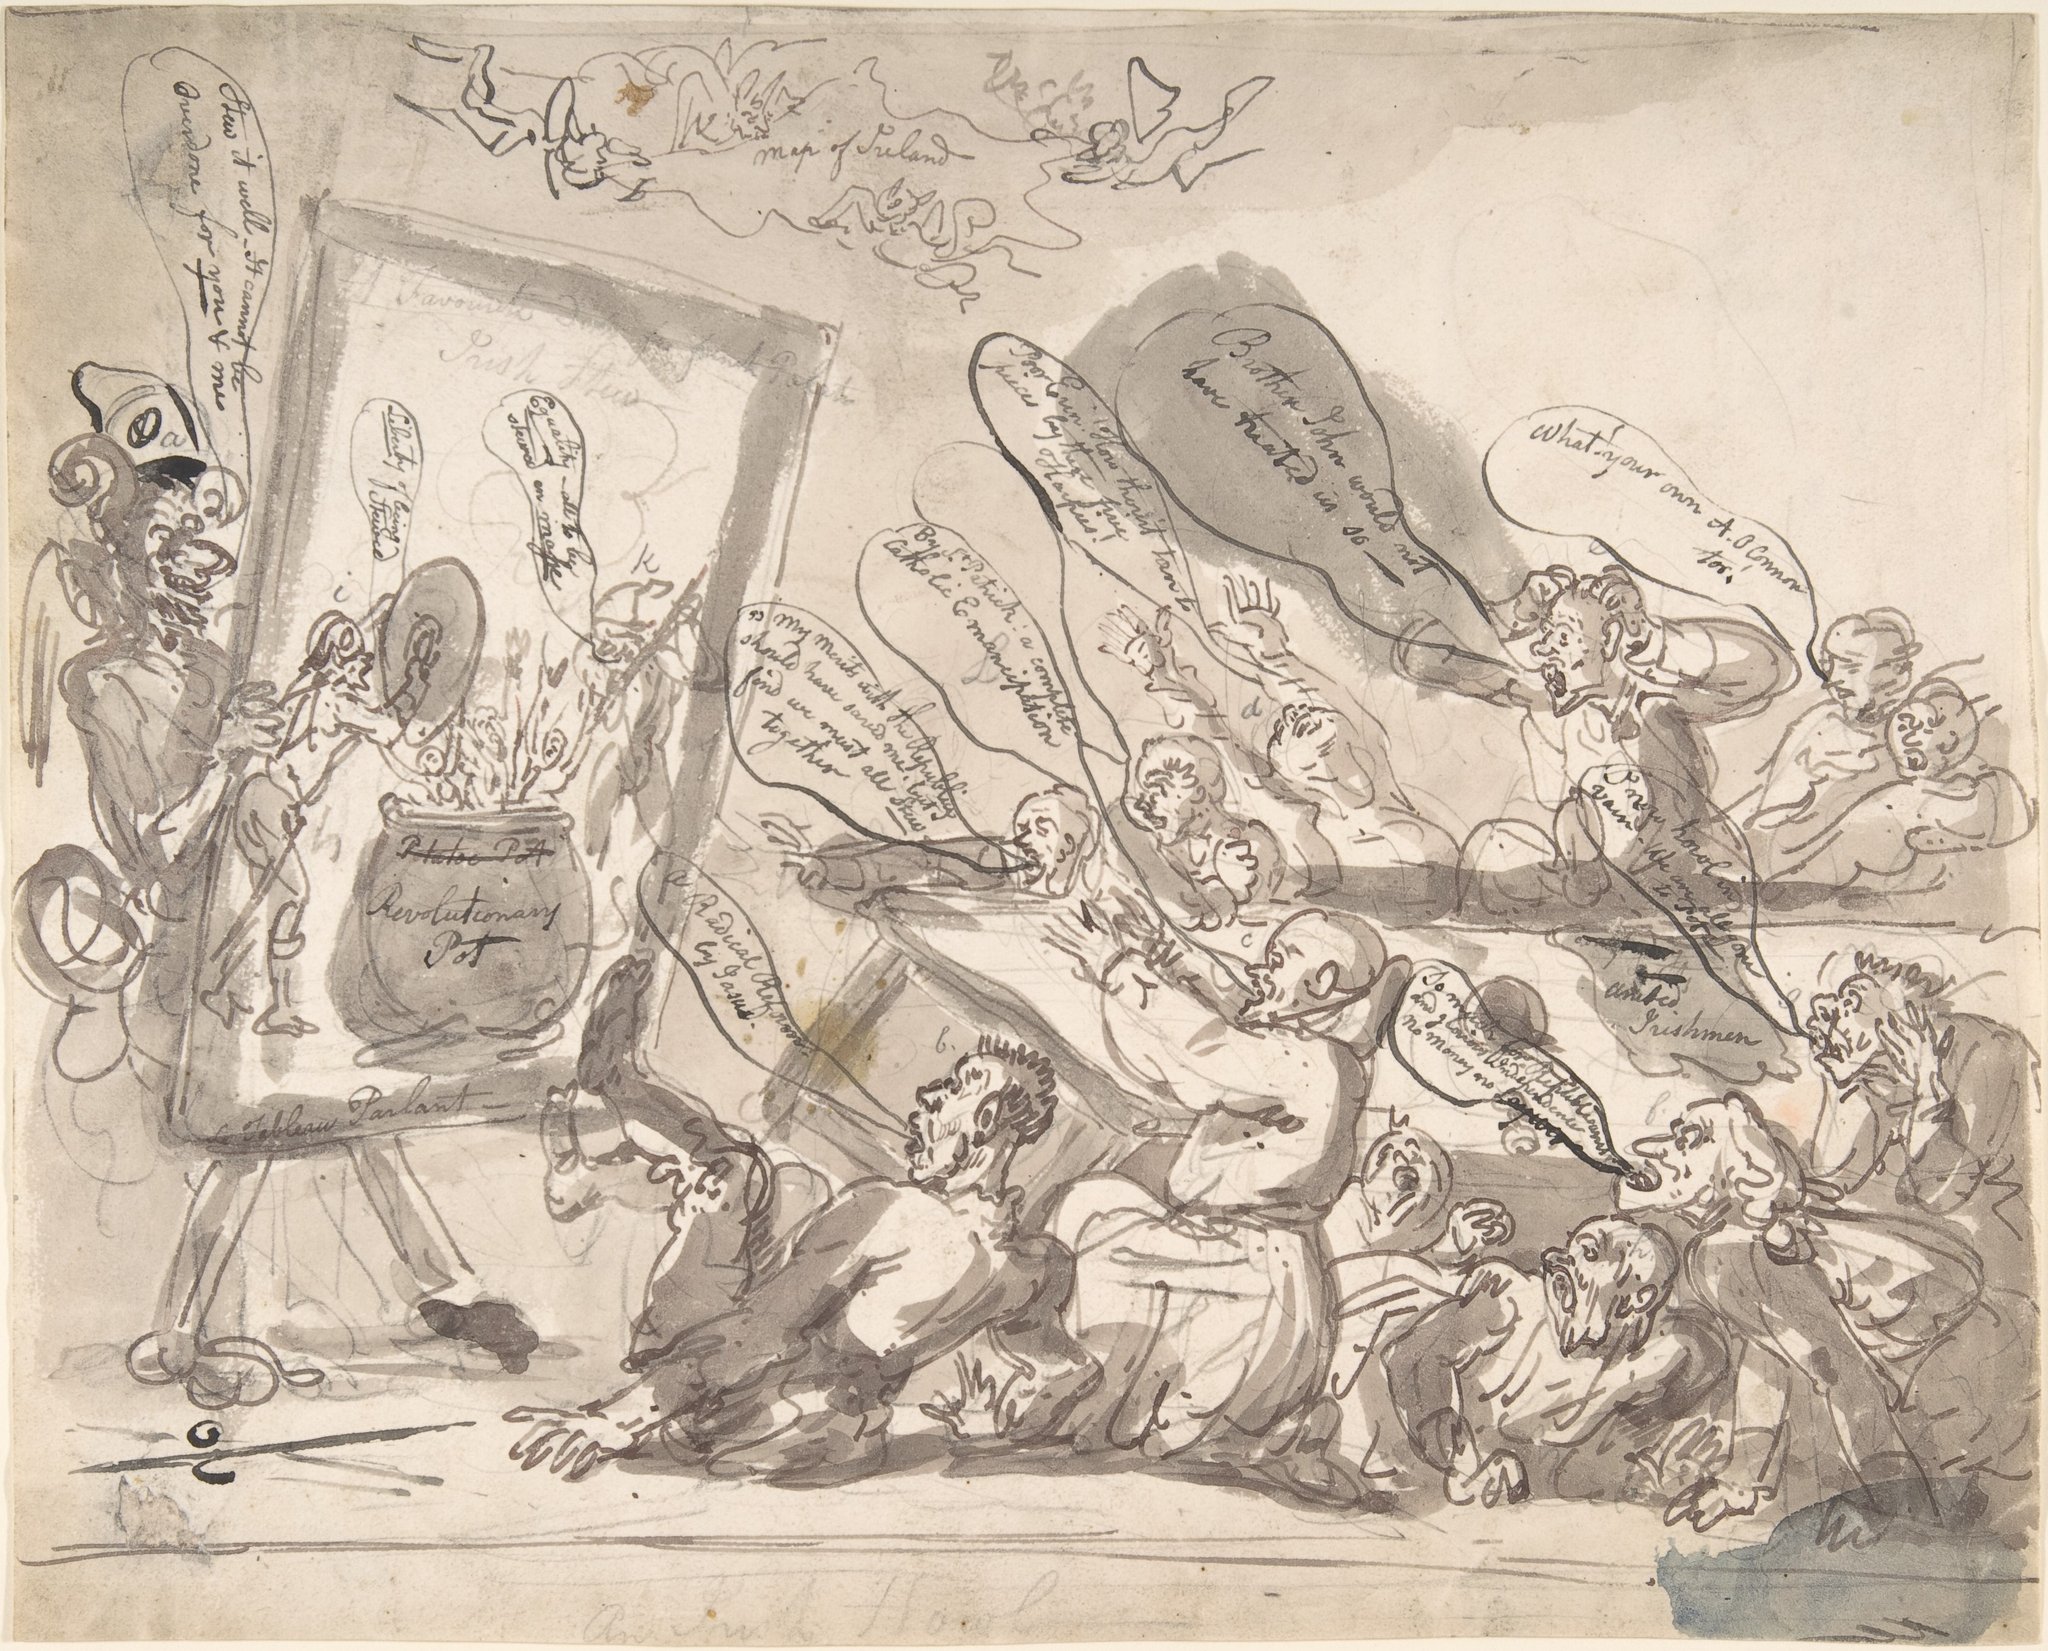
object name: drawing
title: An Irish Howl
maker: thomas rowlandson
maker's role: artist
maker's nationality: british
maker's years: 1757-1827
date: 1799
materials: ink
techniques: brush, pen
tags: satire,men,politics